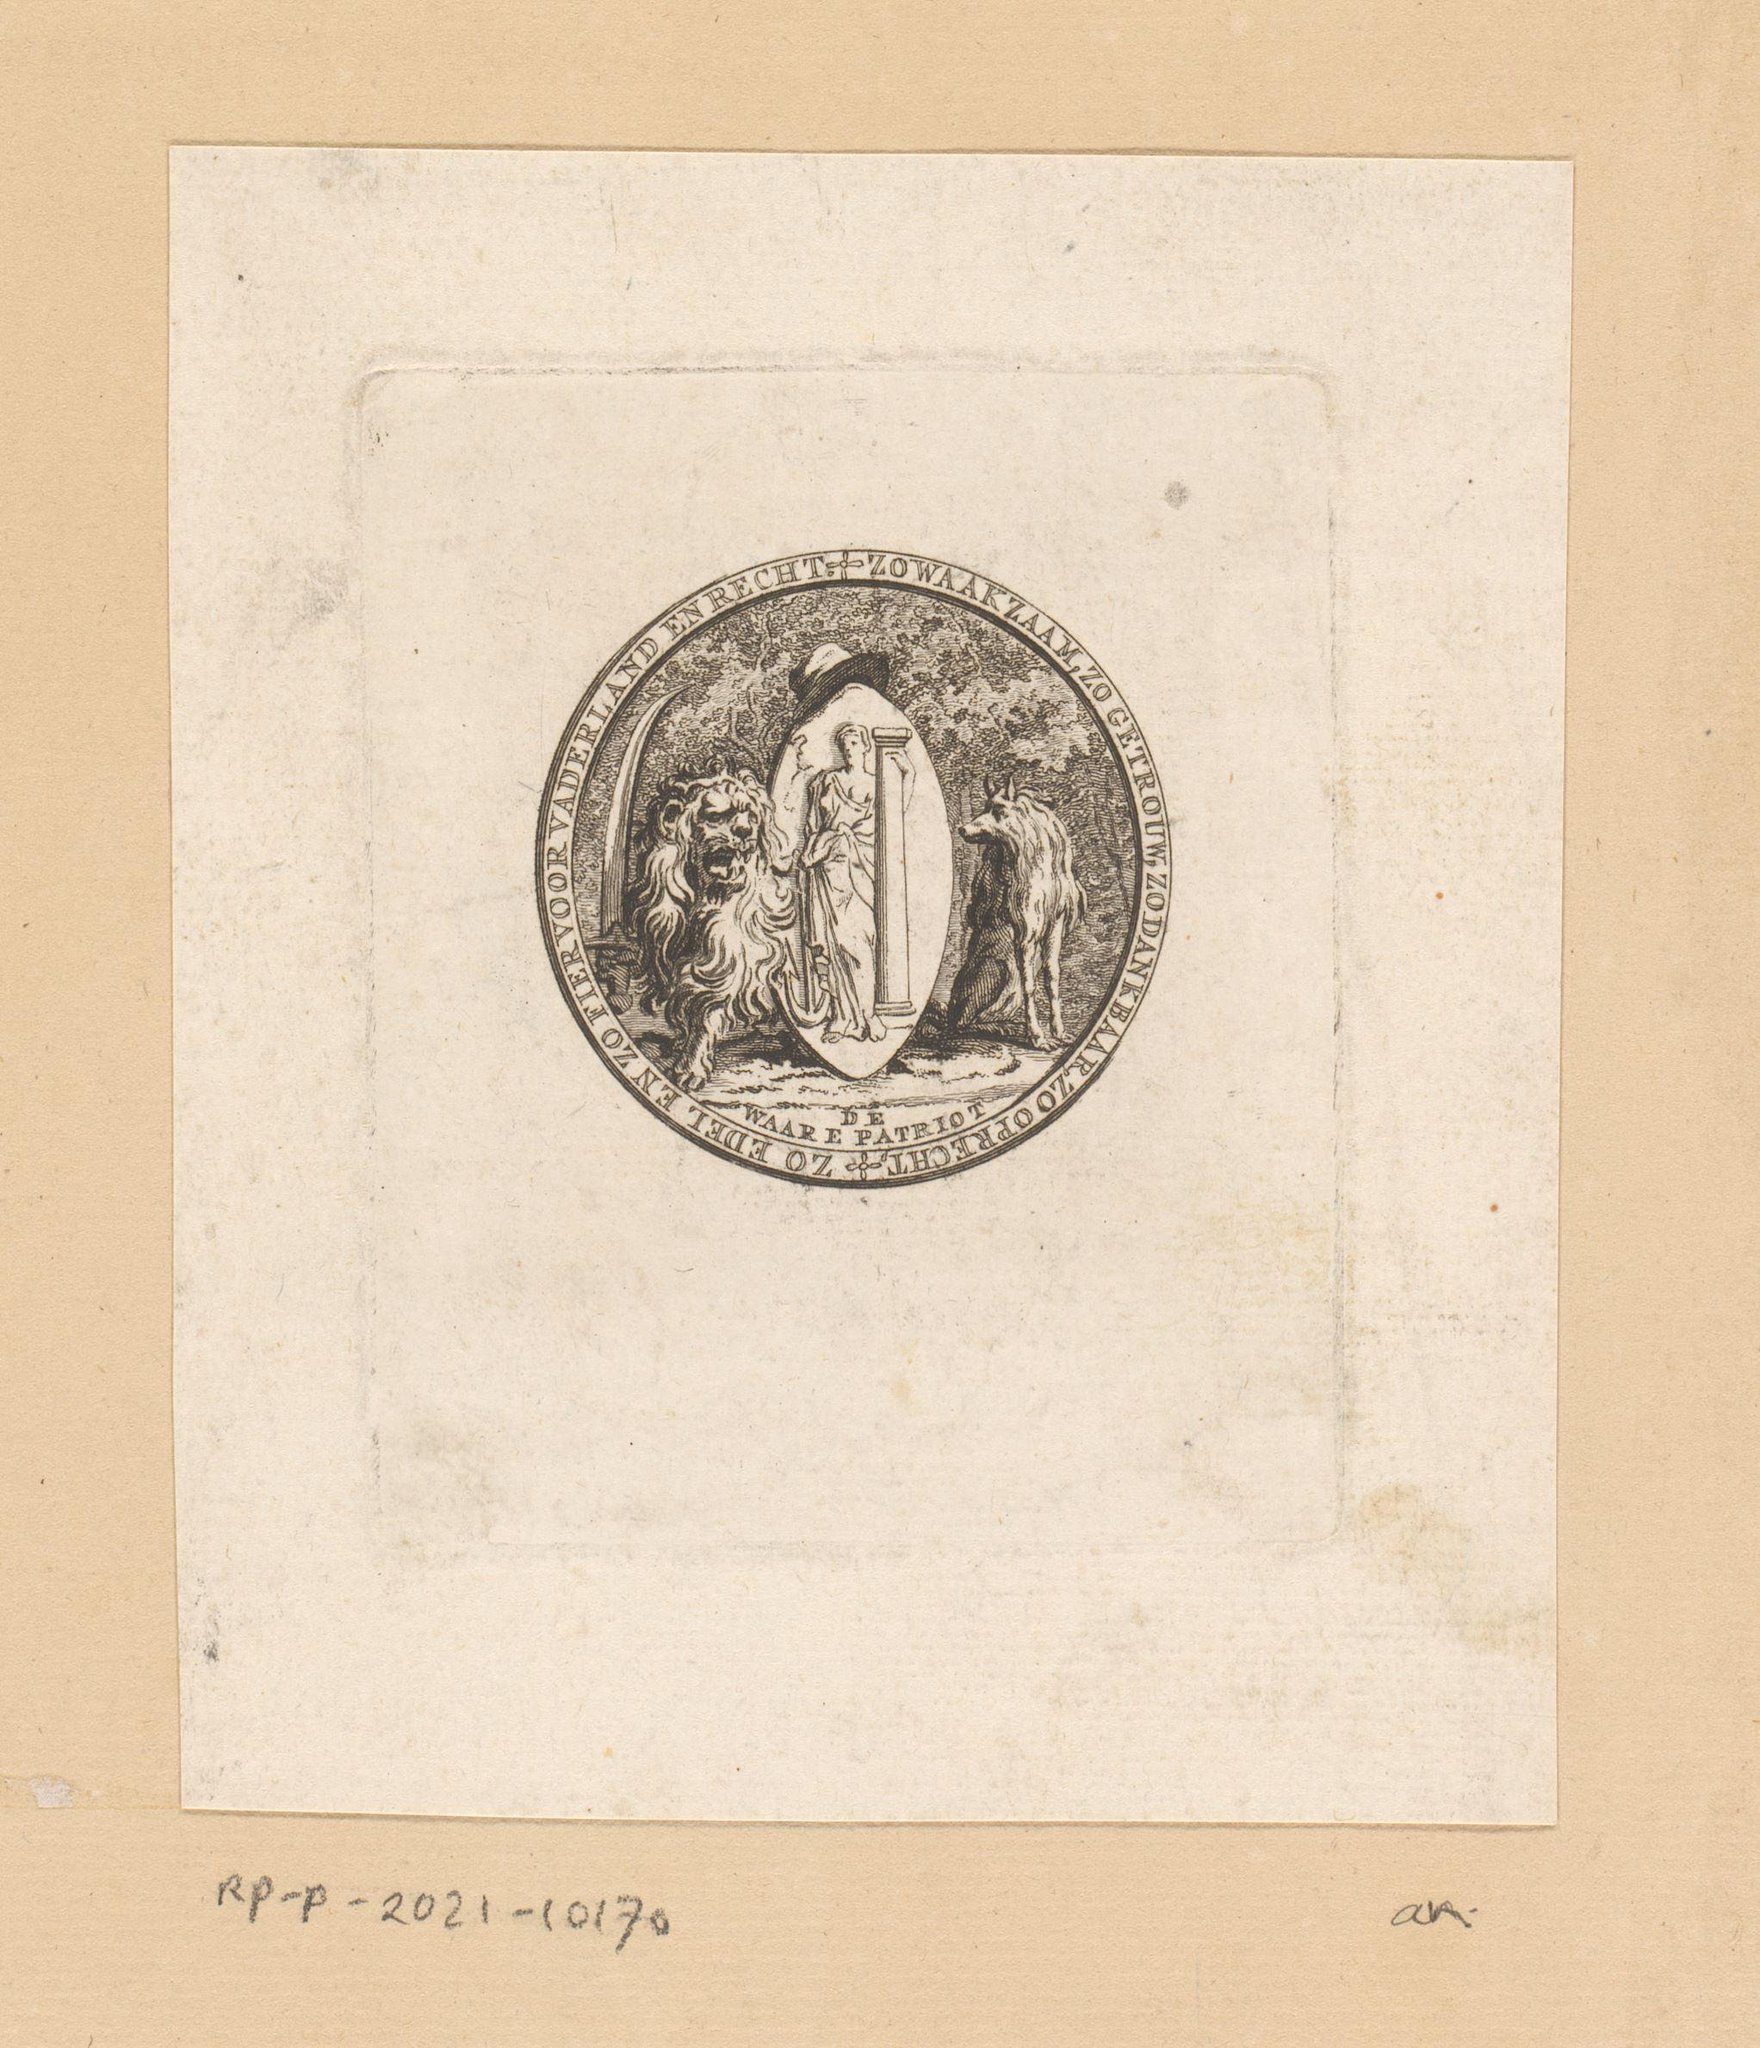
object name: print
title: Medaillon voor de Waare Patriot, ca. 1784-1792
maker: Anonymous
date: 1784-1792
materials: paper, pencil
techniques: etching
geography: northern netherlands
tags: hope, 'spes'; 'speranza divina e certa' (ripa) ~ one of the three theological virtues, medal (considered as a piece of sculpture, regardless of its specific function), patriots (1780-1795)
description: Medaillon of plaquette met een schild met een vrouw staande naast een zuil (Standvastigheid) en een anker (Hoop), ca. 1784-1792. Op het schild rust de vrijheidshoed. Ter weerszijden de Nederlandse leeuw en een keeshond. Met randschrift.